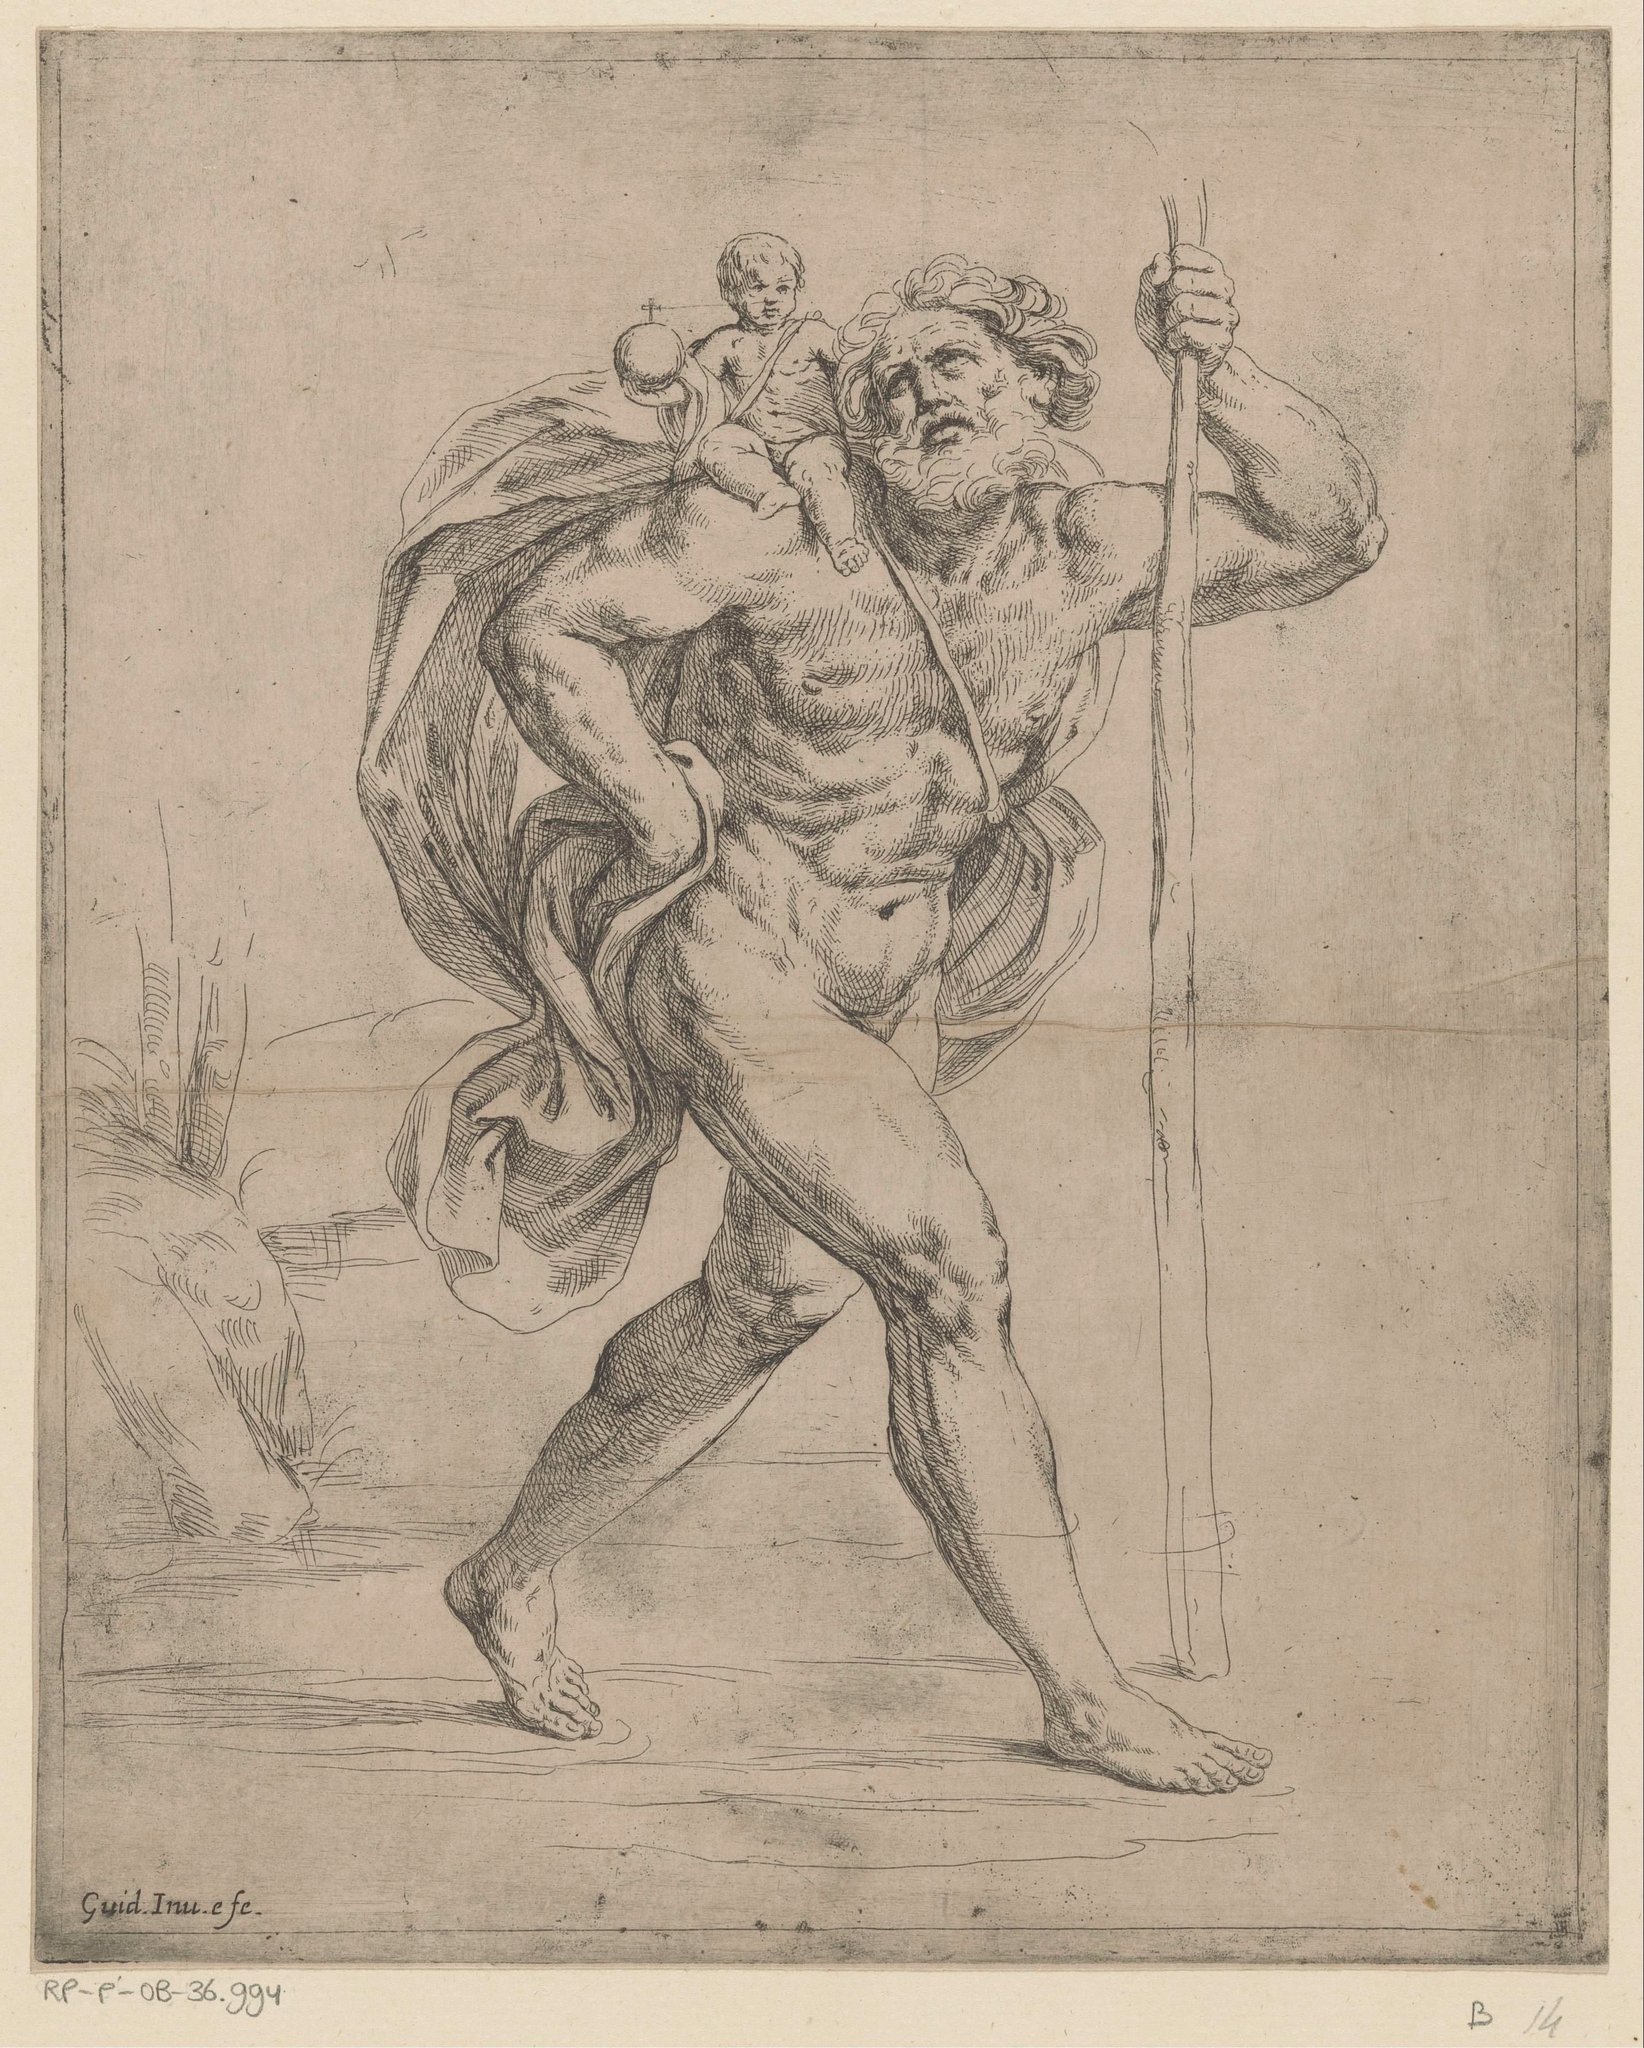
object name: print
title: De heilige Christoffel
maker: guido reni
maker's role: draughtsman, painter, print maker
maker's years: 1575-1642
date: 1585-1642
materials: paper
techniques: etching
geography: italy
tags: the giant and martyr christophorus; possible attributes: palm-tree (with bunches of dates, or withered), infant christ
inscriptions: collector's mark: Lugt 240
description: De heilige Christoffel lopend met een stok en het Christuskind op zijn schouder.